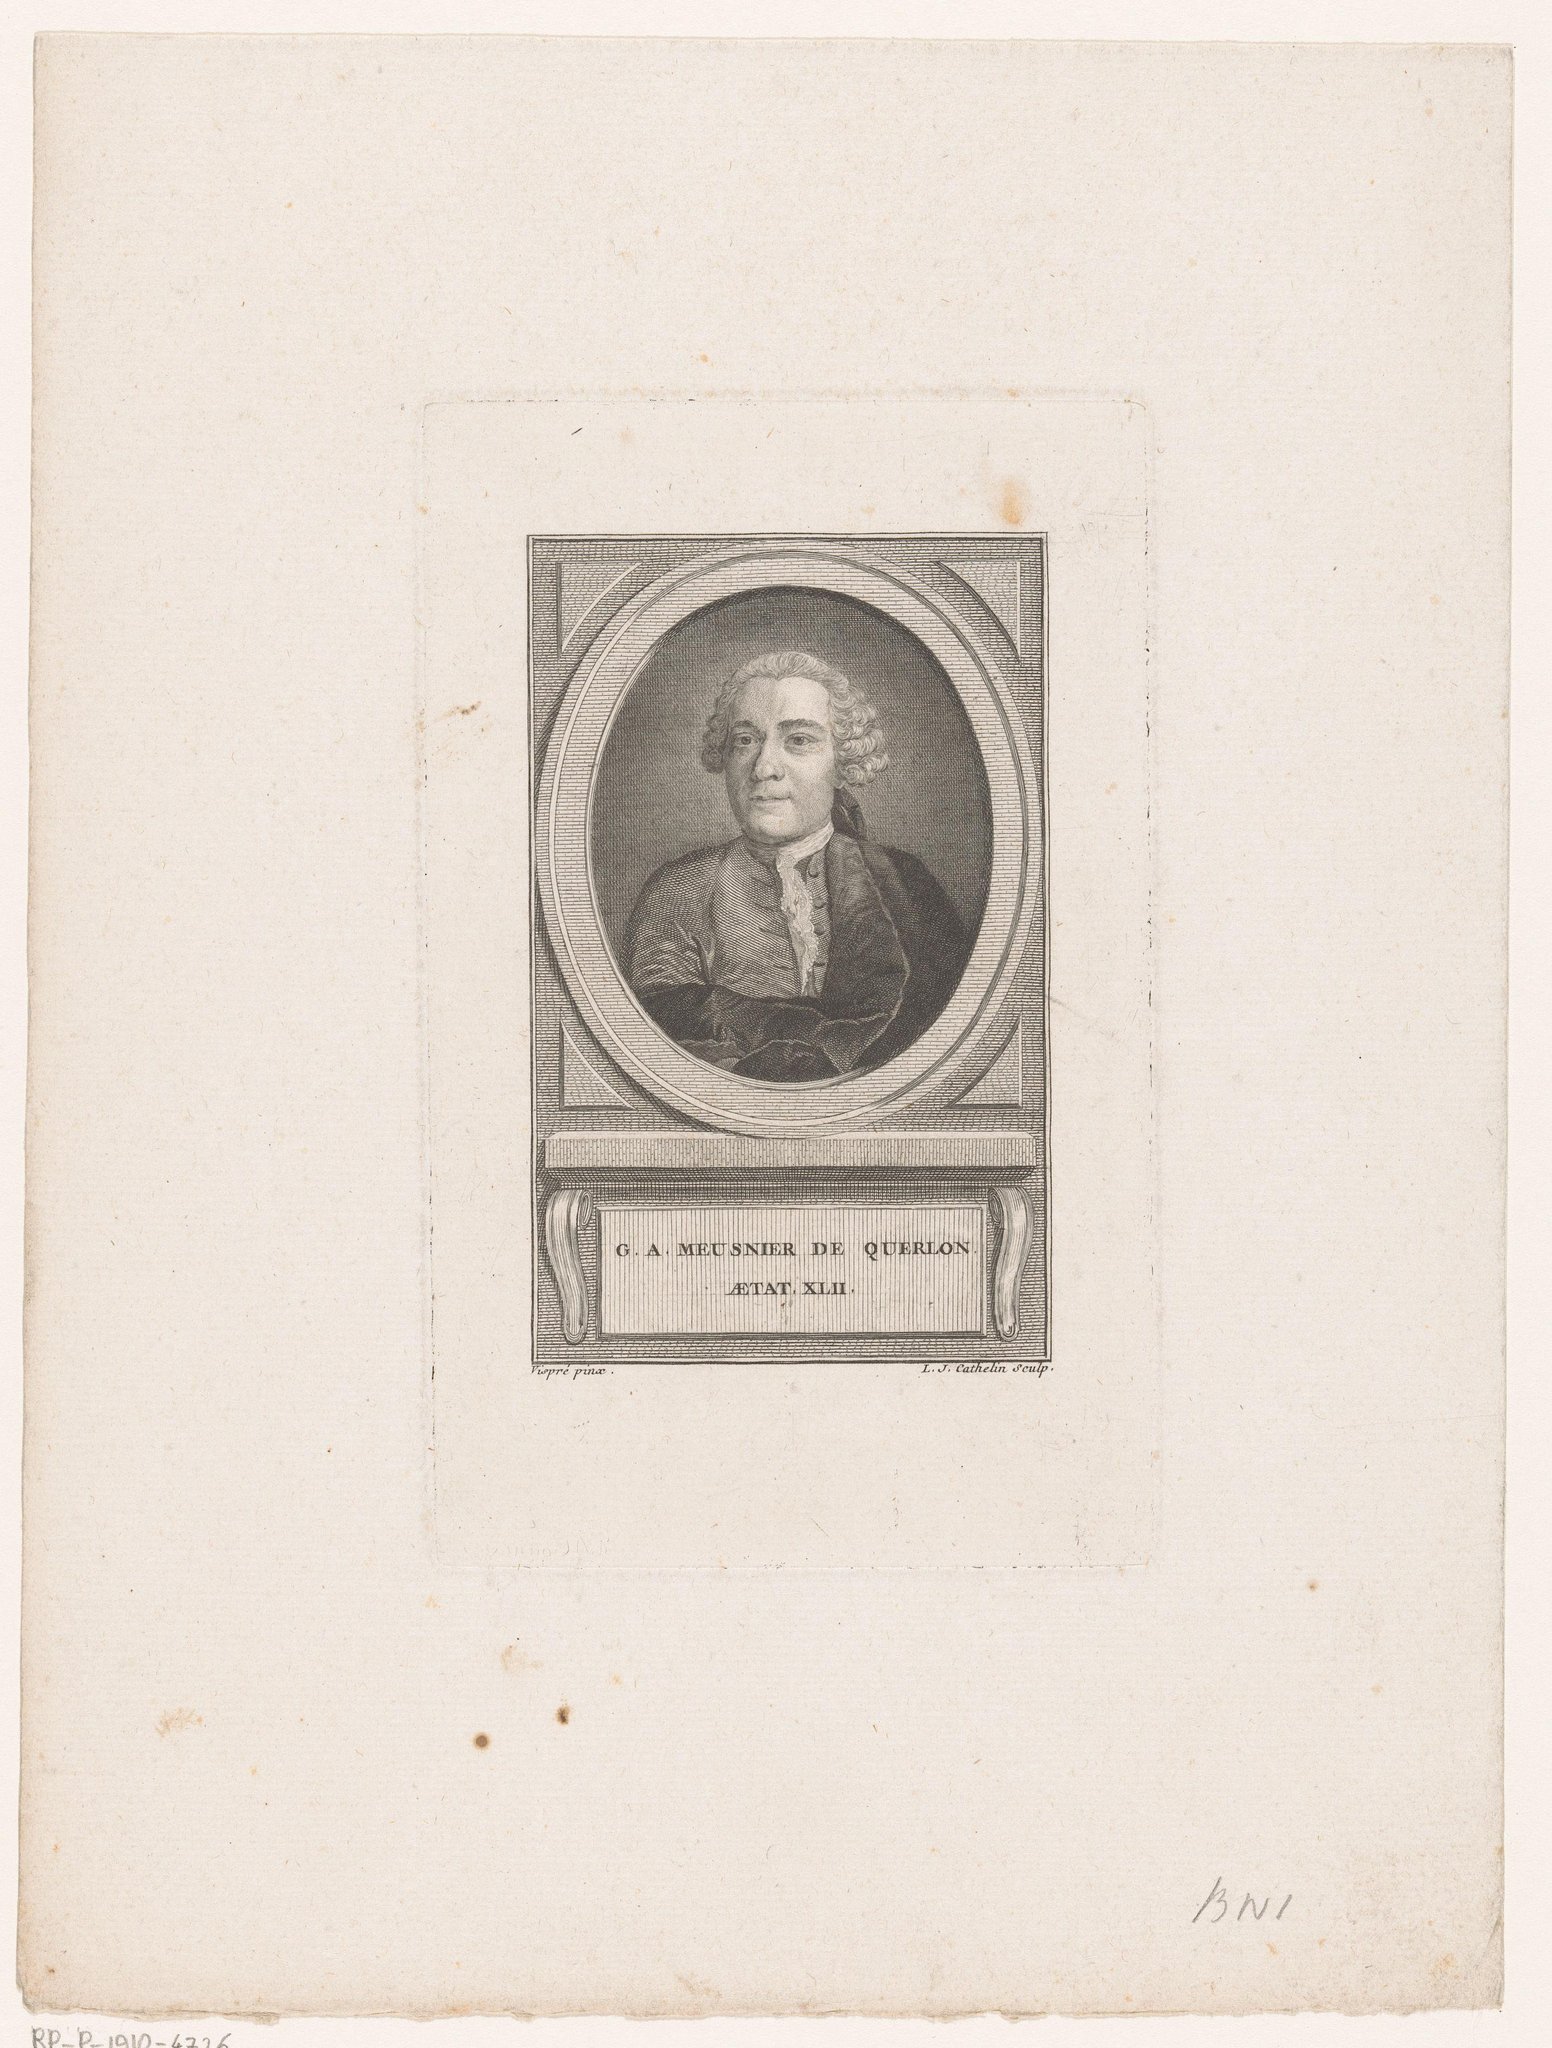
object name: print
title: Portret van Anne Gabriel Meusnier de Querlon, op 42-jarige leeftijd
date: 1748-1804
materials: paper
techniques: engraving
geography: france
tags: historical persons, portrait of a writer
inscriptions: collector's mark: Lugt 2228